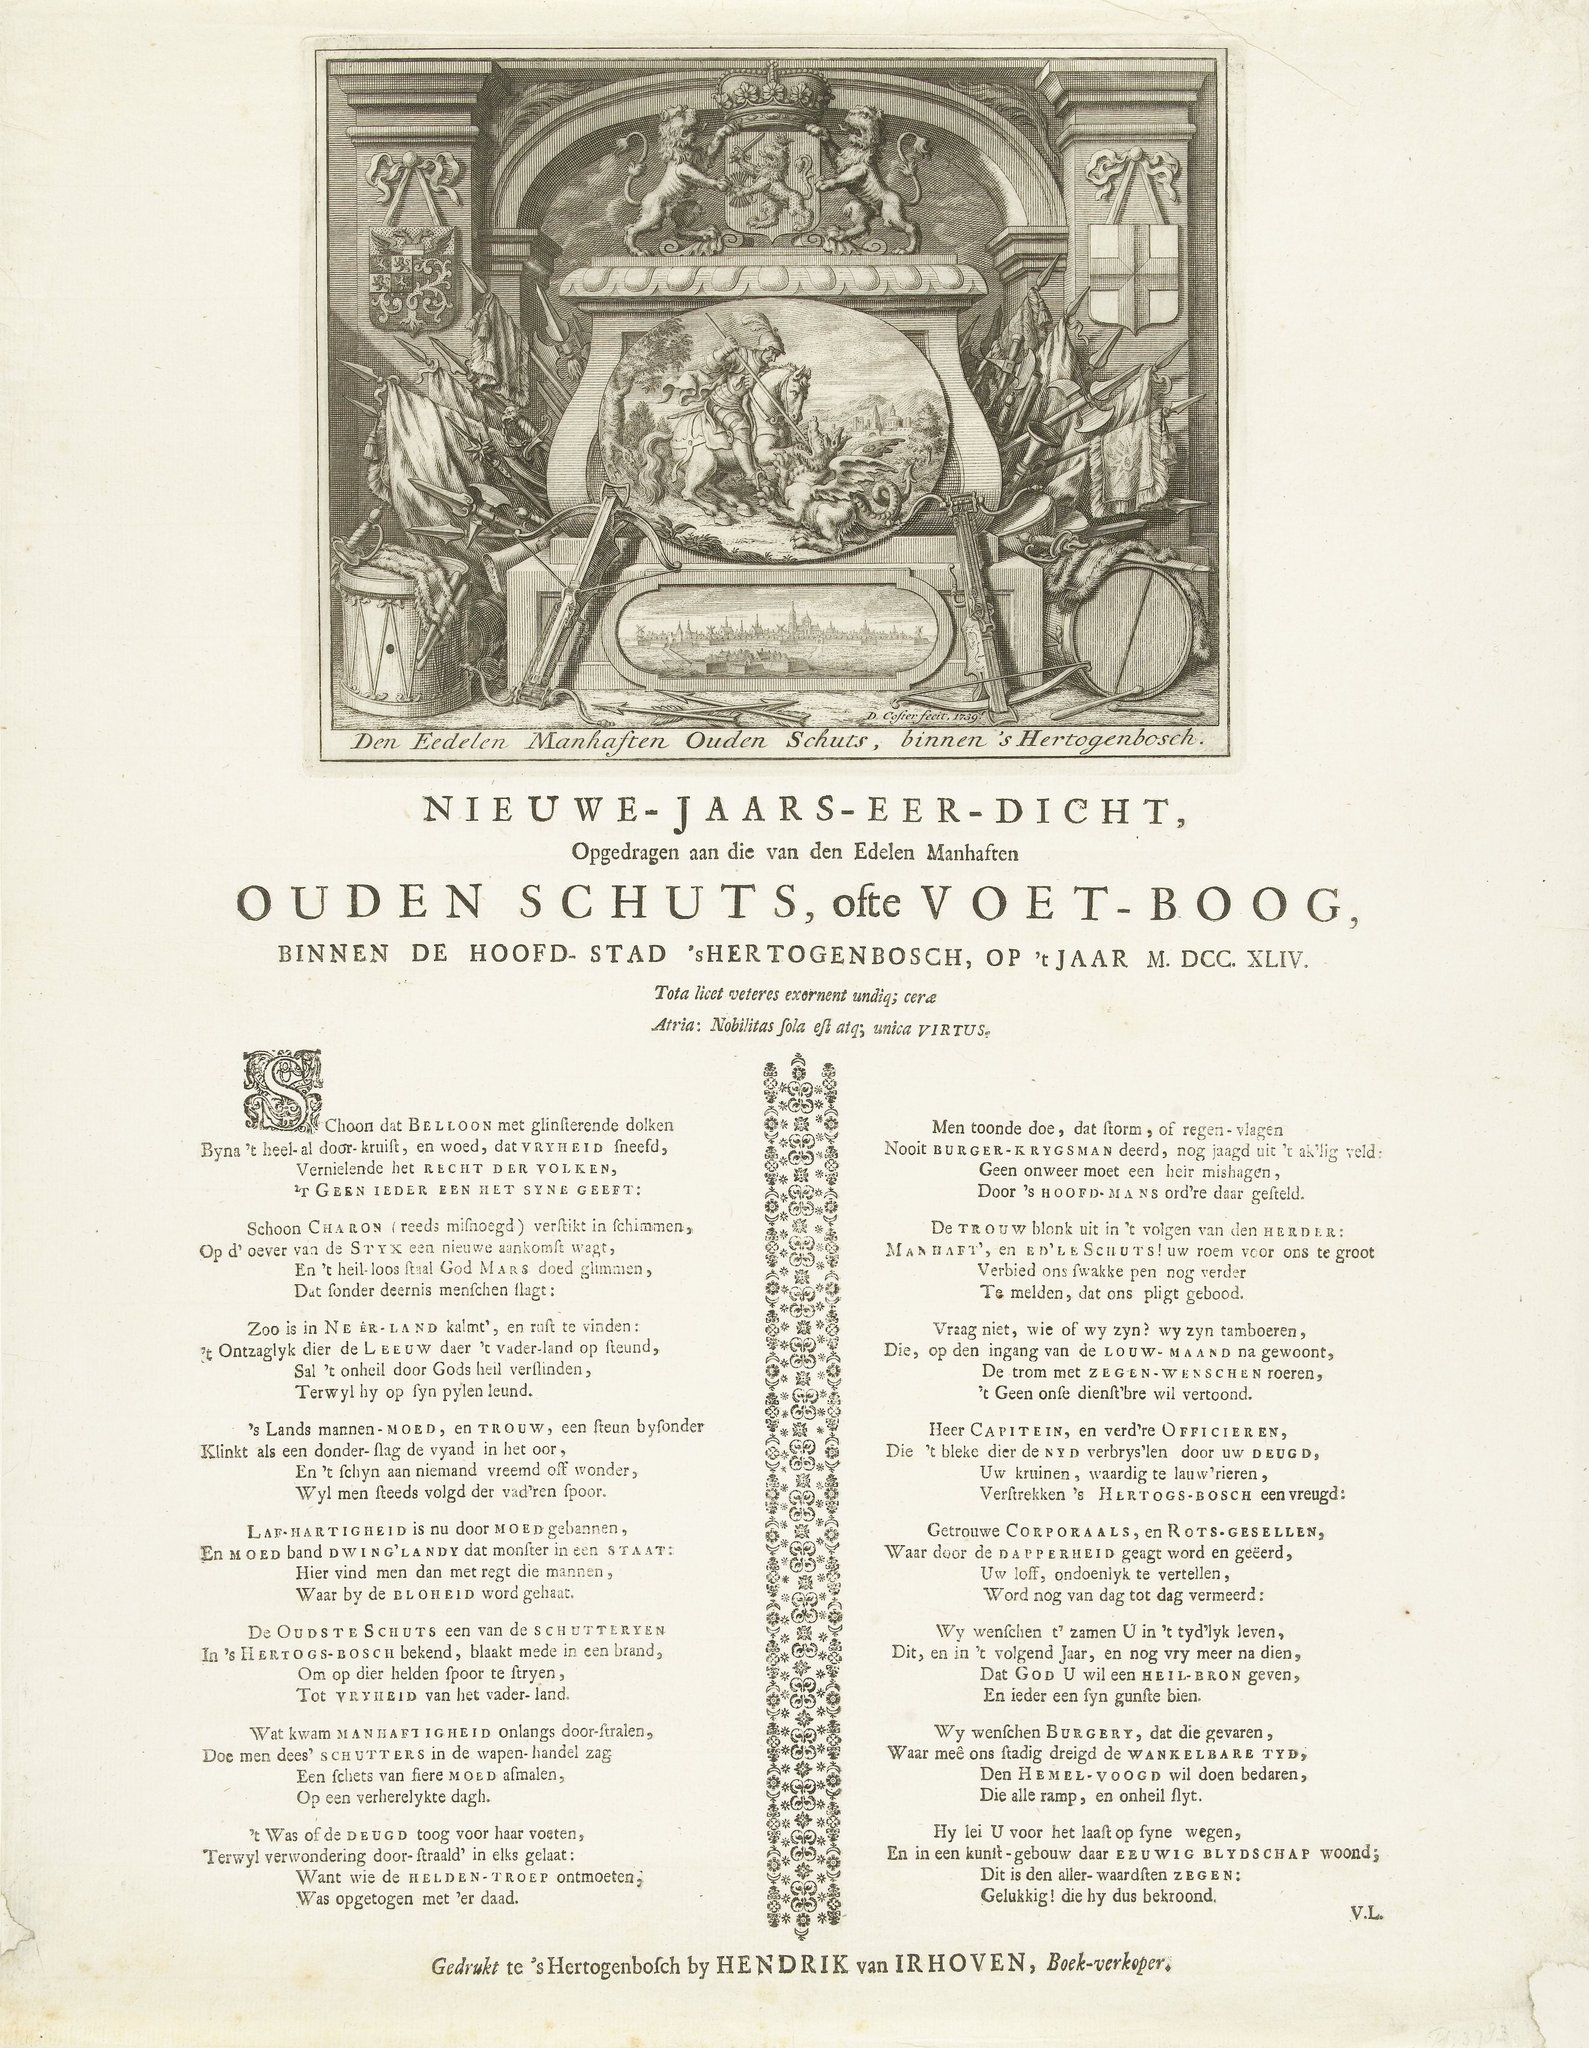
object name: print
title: Nieuwe-Jaars-Eer-Dicht, Opgedragen aan die van den Edelen Manhaften Ouden Schuts, ofte Voet-boog, Binnen de Hoofd-stad s'Hertogenbosch, op 't Jaar MDCCXLIV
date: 1739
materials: paper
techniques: engraving, etching, letterpress printing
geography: den bosch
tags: warfare; military affairs (+ citizen soldiery, civil guard, citizen militia), the warrior martyr george (georgius); possible attributes: banner (red cross on white field), (red) cross, dragon, (white) horse, broken lance, shield (with cross), sword, den bosch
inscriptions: collector's mark: Lugt 2228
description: Nieuwjaarsprent van de schutterij De Oude Schuts of Voetboogdoelen van de stad 's-Hertogenbosch voor het jaar 1744. Embleem met Sint Joris die de draak doodt boven een gezicht op Den Bosch, links en rechts wapens, vaandels en de wapena van Den Bosch en Sint-Joris. Op het blad onder de plaat een vers in twee kolommen.